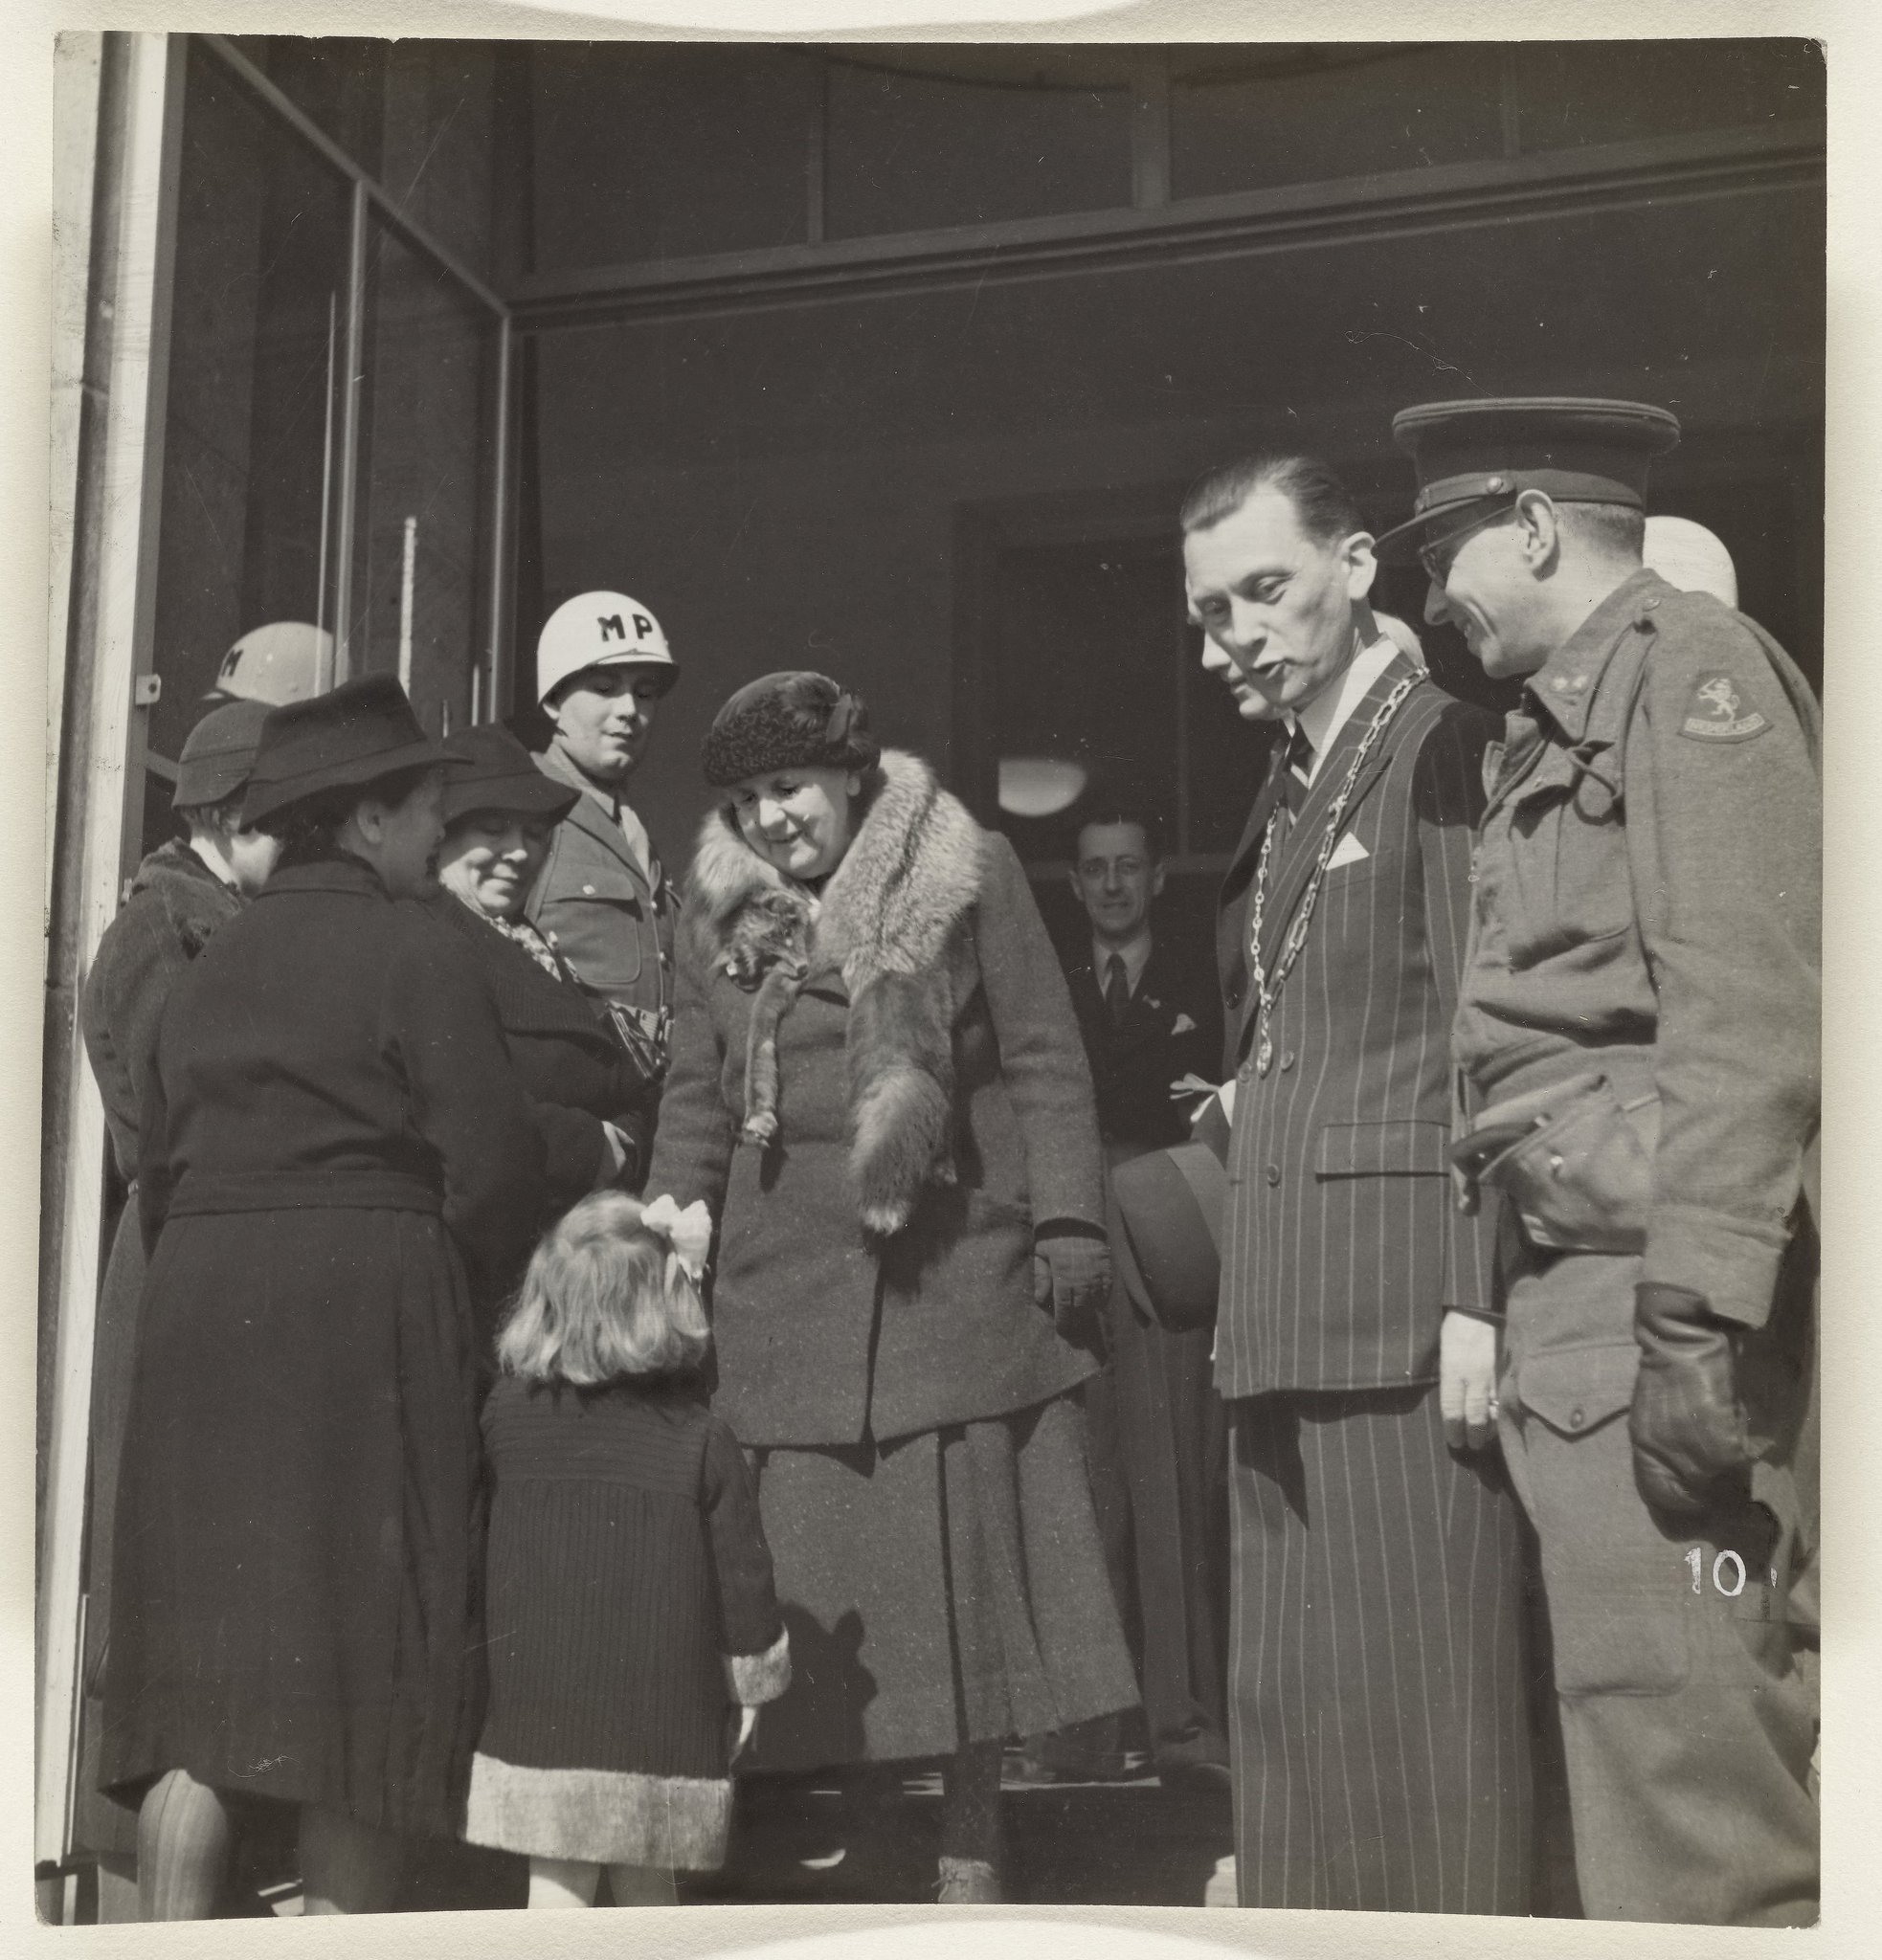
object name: photograph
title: Koningin Wilhelmina op bezoek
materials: photographic support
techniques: photography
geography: netherlands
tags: the hague, print maker, wilhelmina of the netherlands, netherlands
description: Koningin Wilhelmina, kort na de bevrijding, schudt een klein meisje de hand. Om haar heen staan MP's en een burgemeester en een paar vrouwen.